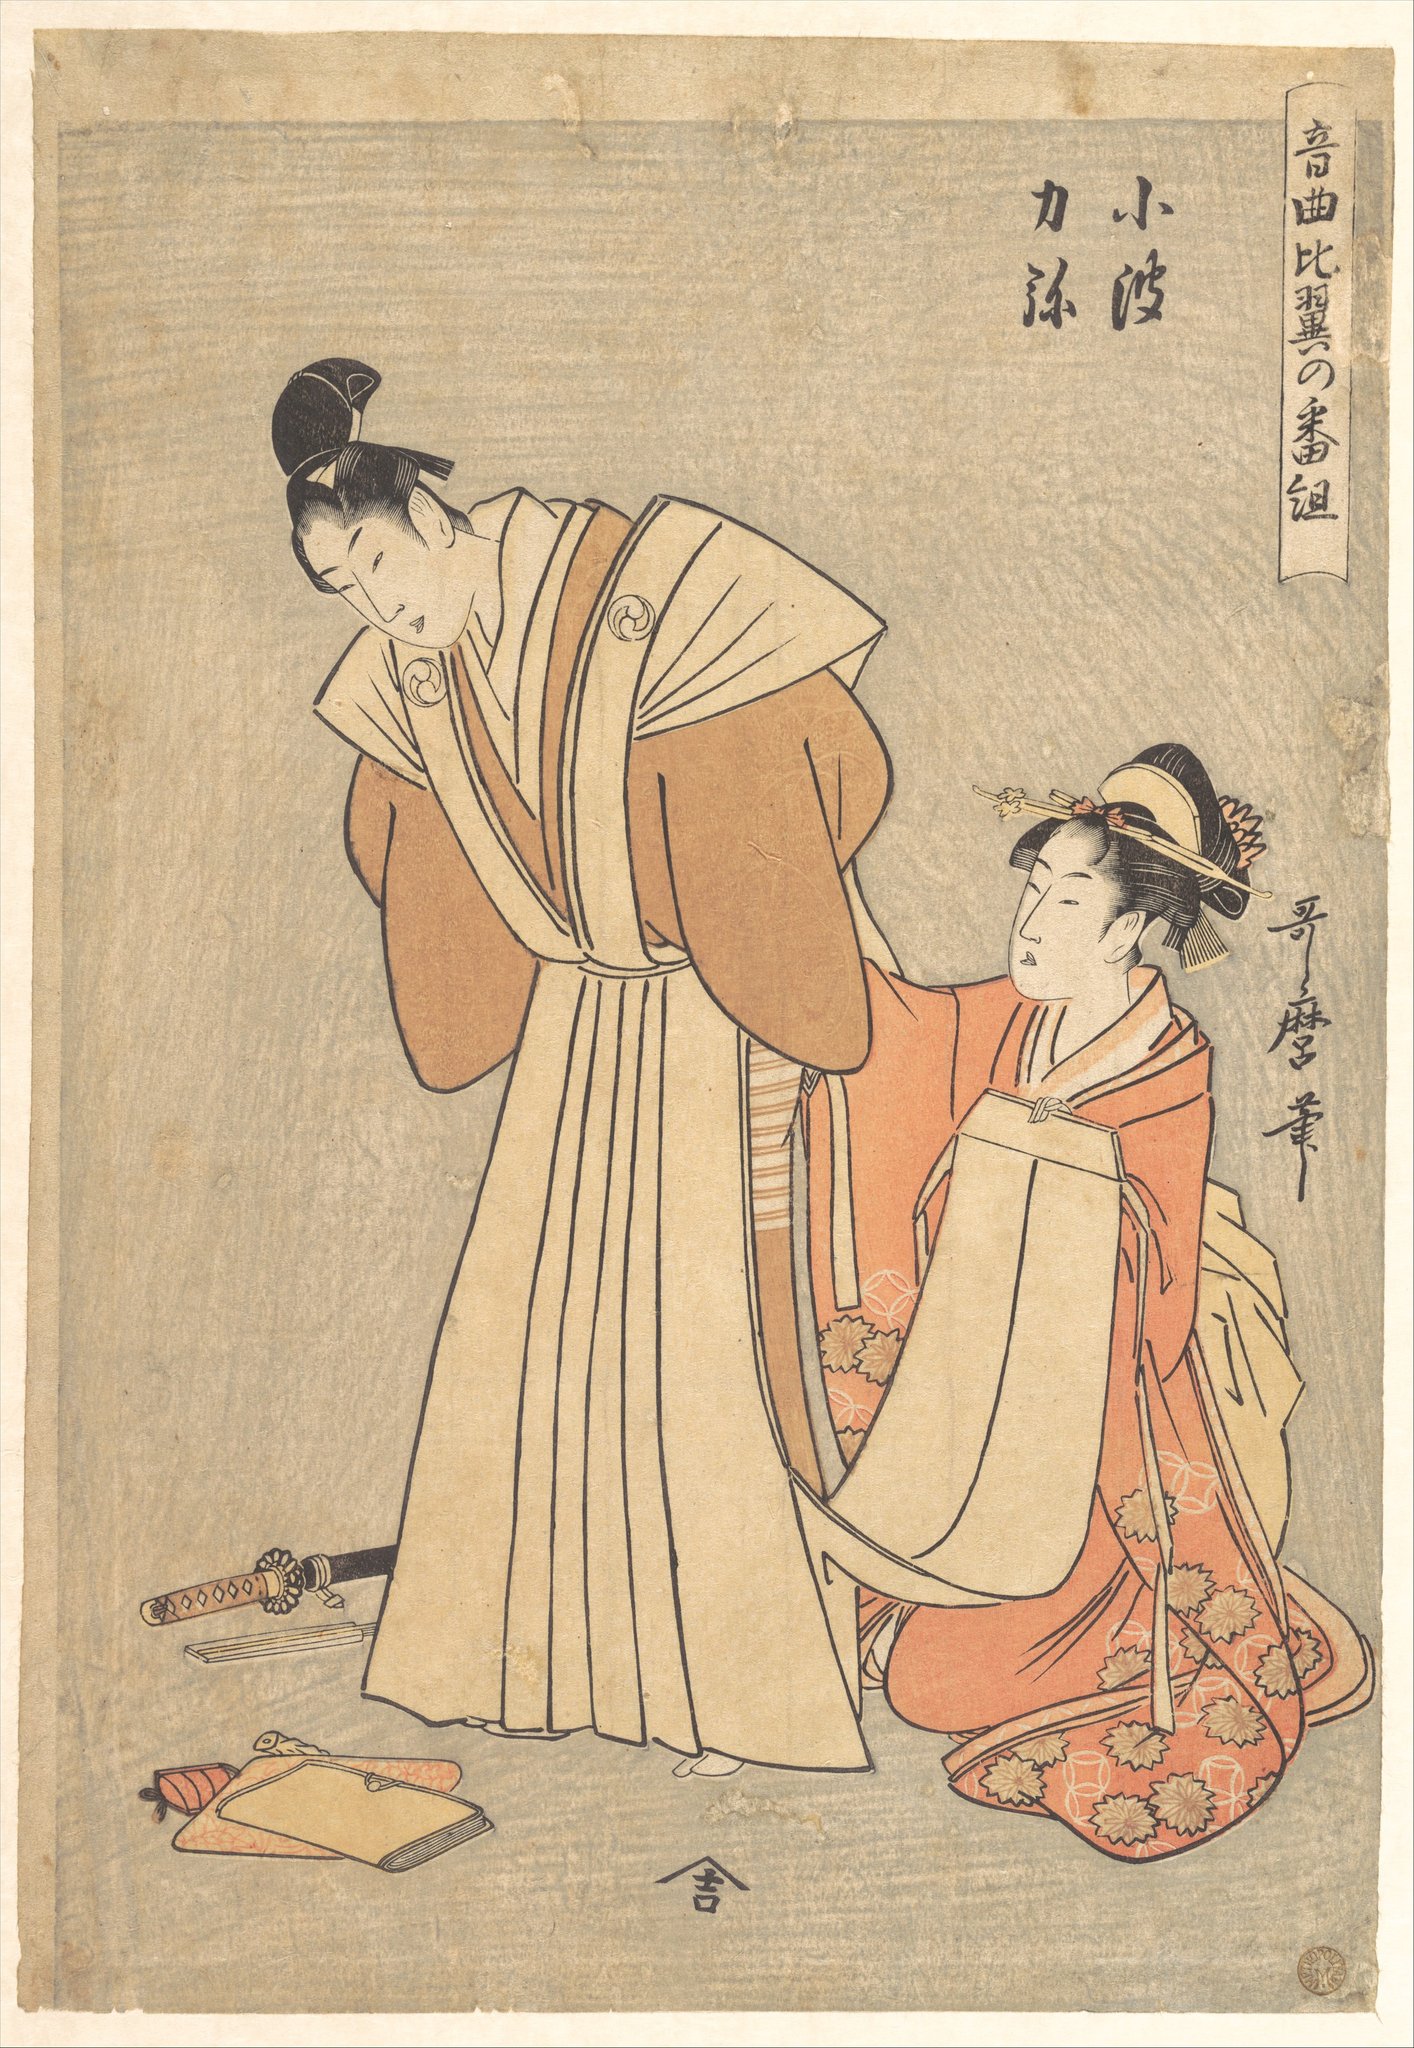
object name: print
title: Rikiya and Konami, from the series A Program with Music about Loving Couples (Ongyoku hiyoku no bangumi)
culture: japanese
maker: kitagawa utamaro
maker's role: artist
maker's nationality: japanese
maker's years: 1754-1806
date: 1798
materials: ink, paper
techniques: woodblock print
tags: men,women